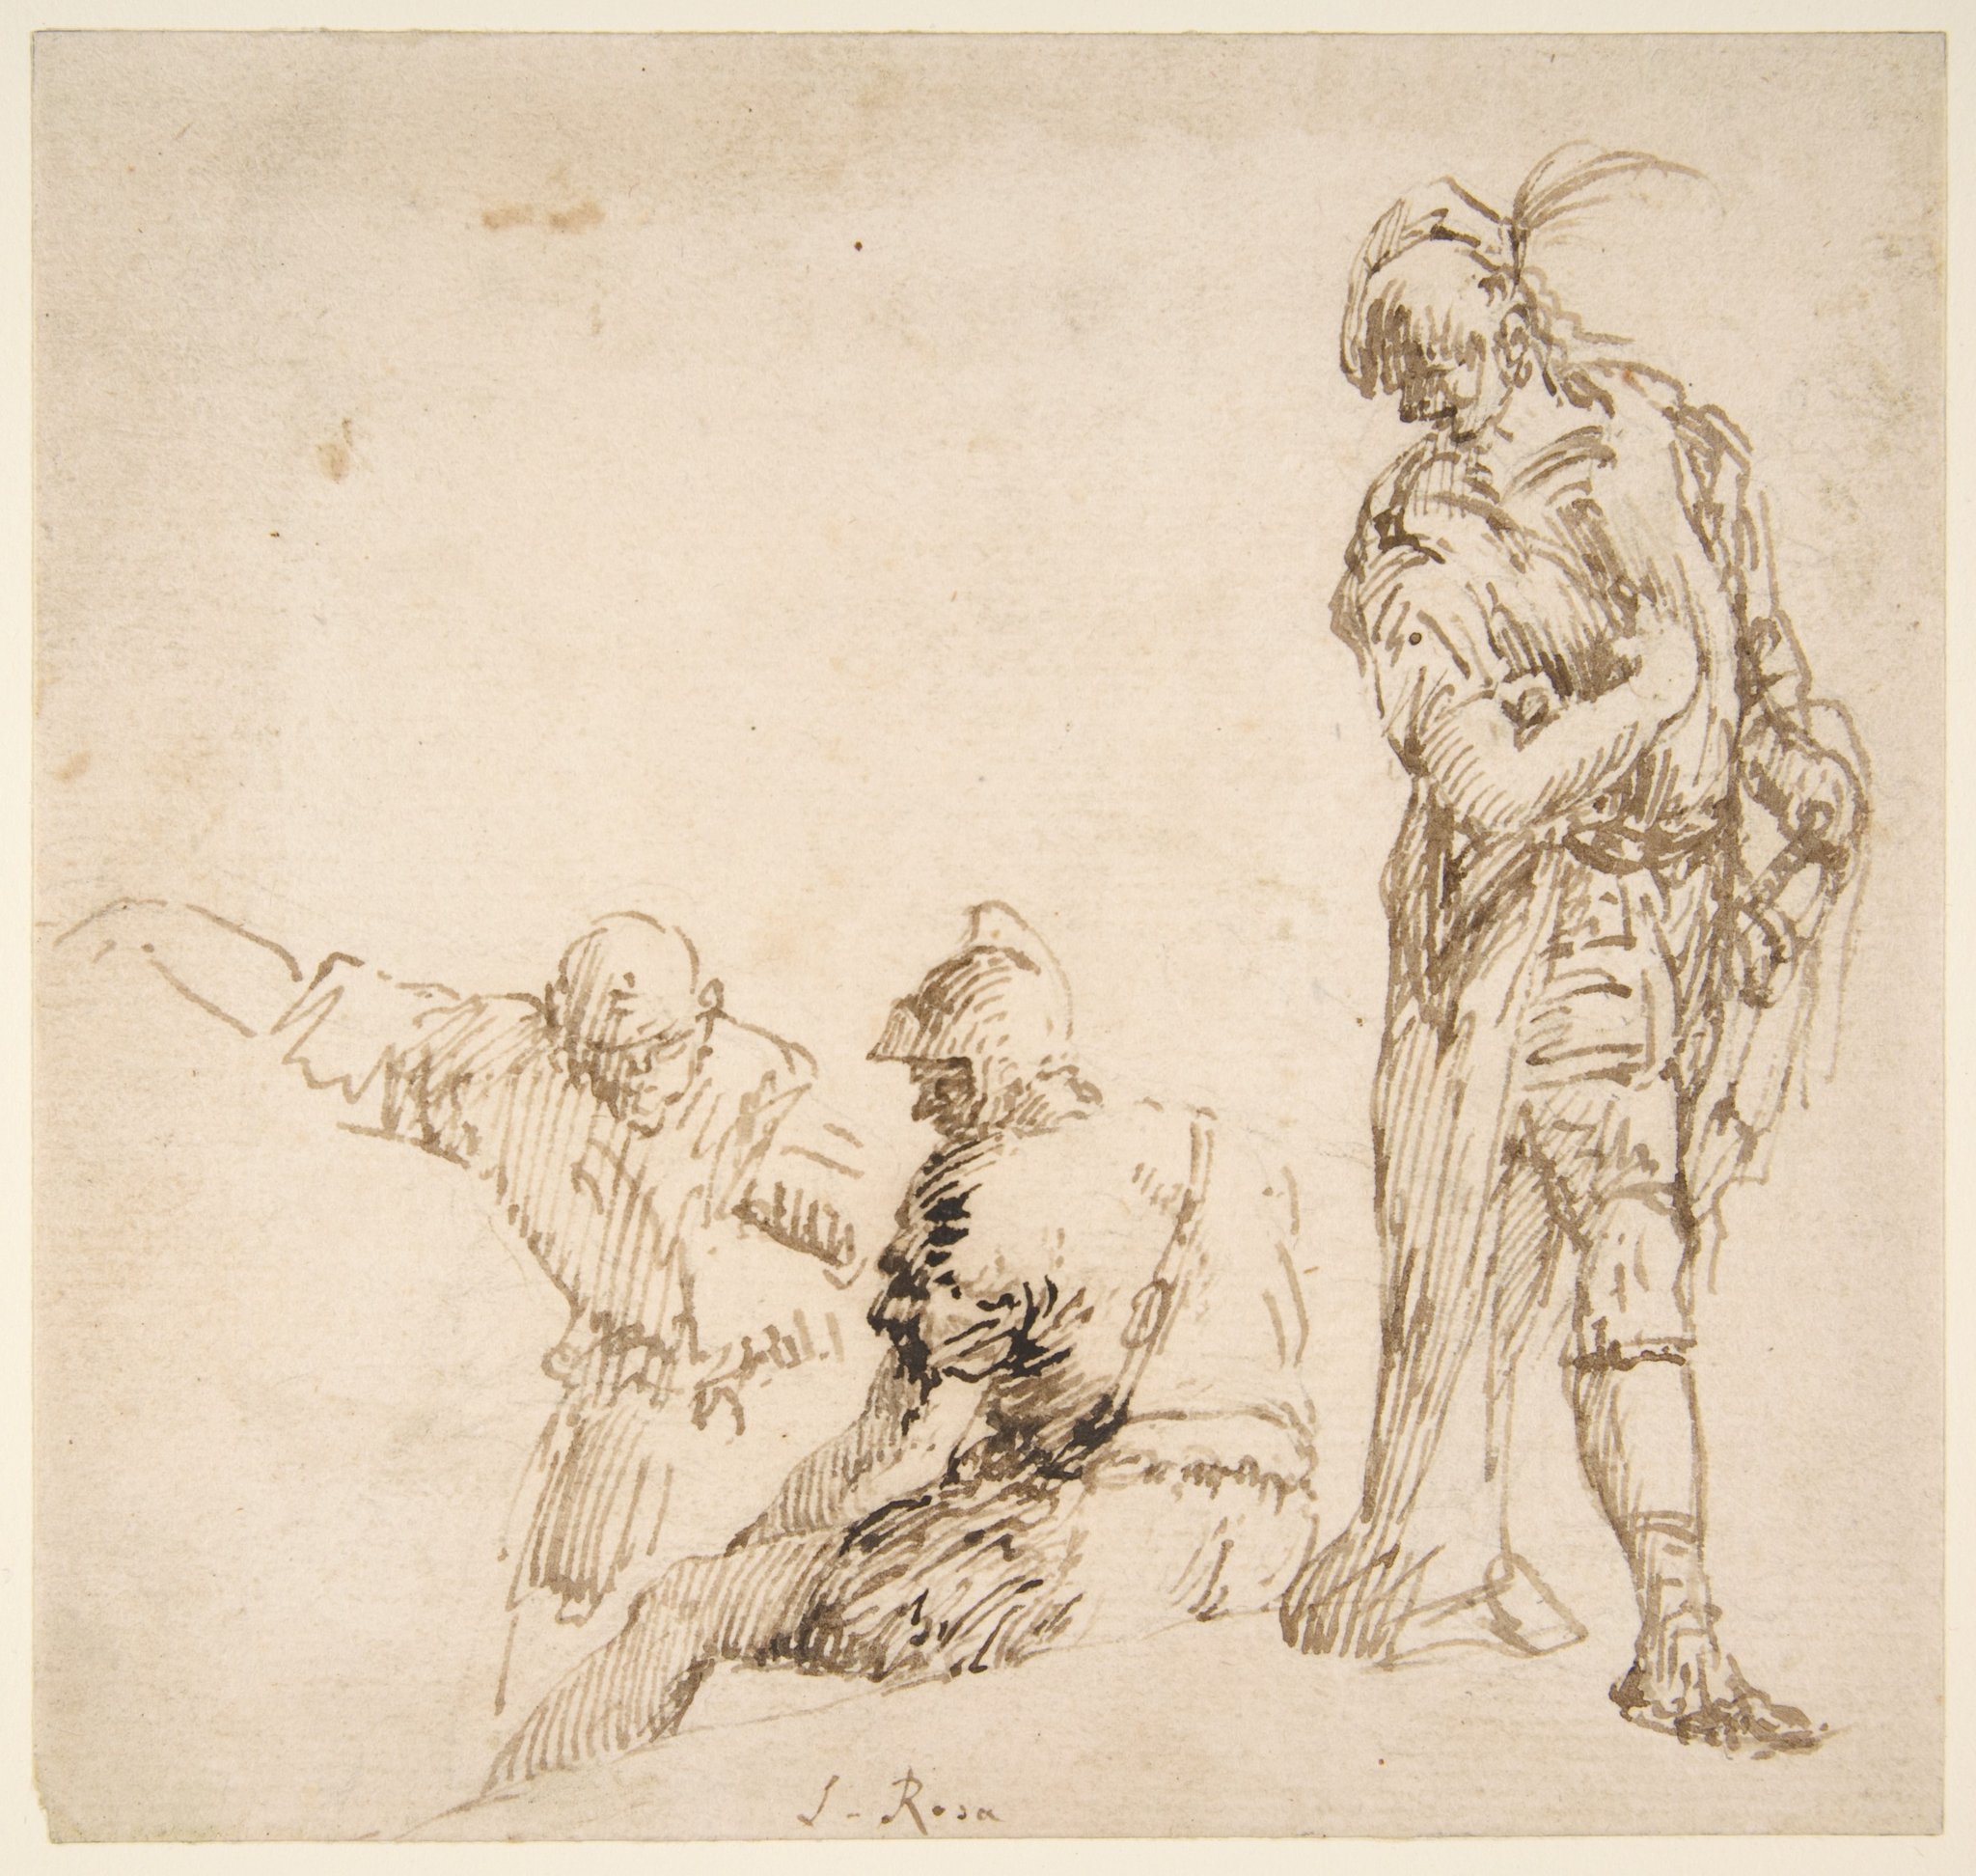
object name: drawing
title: Figure studies: seated and standing men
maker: salvator rosa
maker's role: artist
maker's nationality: italian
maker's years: 1615-1673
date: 1615-1673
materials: chalk, ink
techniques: pen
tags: soldiers,men